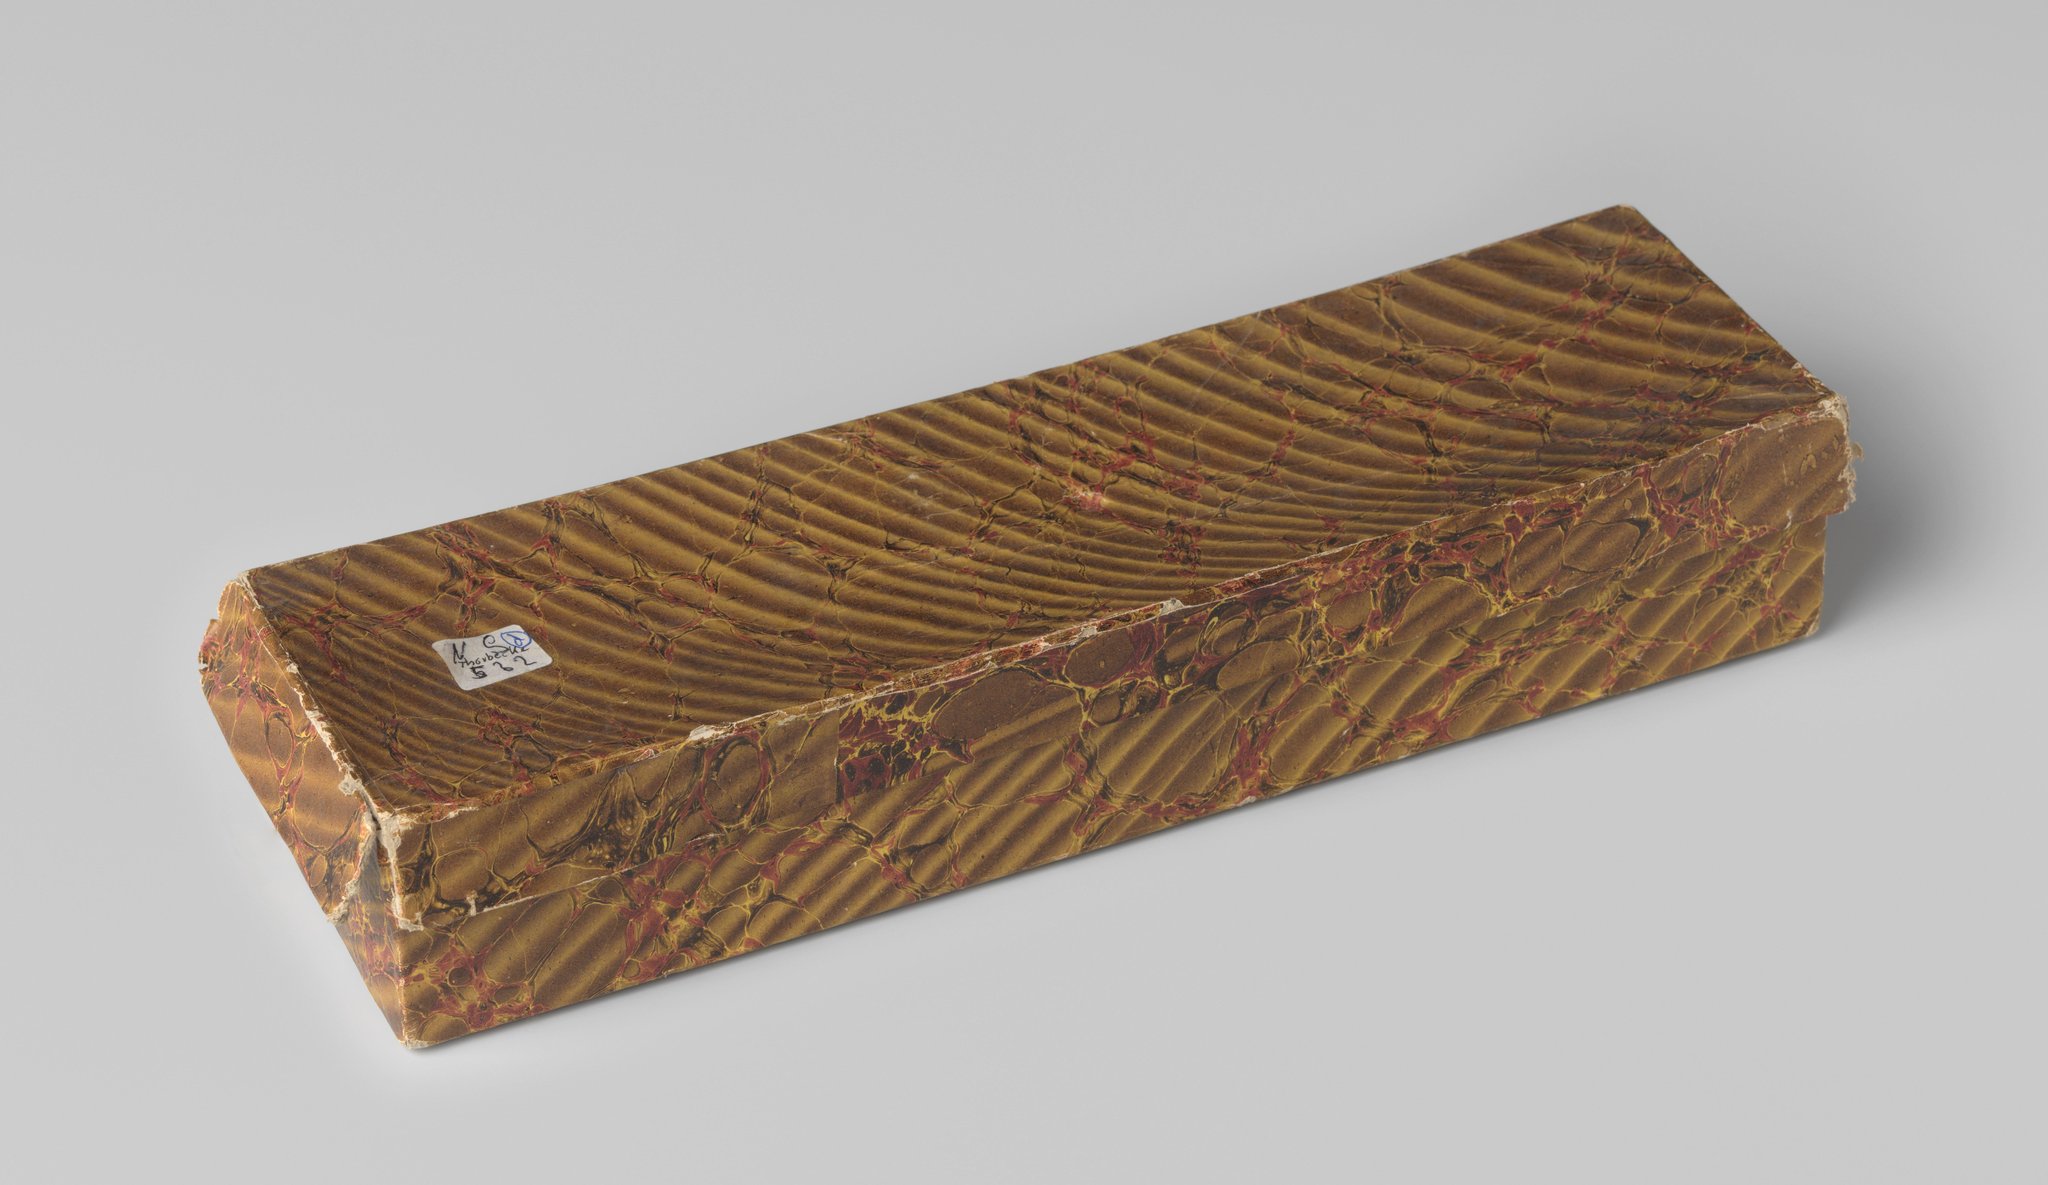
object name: box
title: Rechthoekige kartonnen doos met deksel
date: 1850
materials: cardboard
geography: the hague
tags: johan rudolf thorbecke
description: Rehthoekige doos van karton, met deksel. Aan de binnenzijde van het deksel staat gestempeld: Fabriek/ van/ gouden & zilveren borduursels galonnen/ militaire ornementen enz./ A.A.Knuyver/ Gedempte Raam no. 11 's Hage.